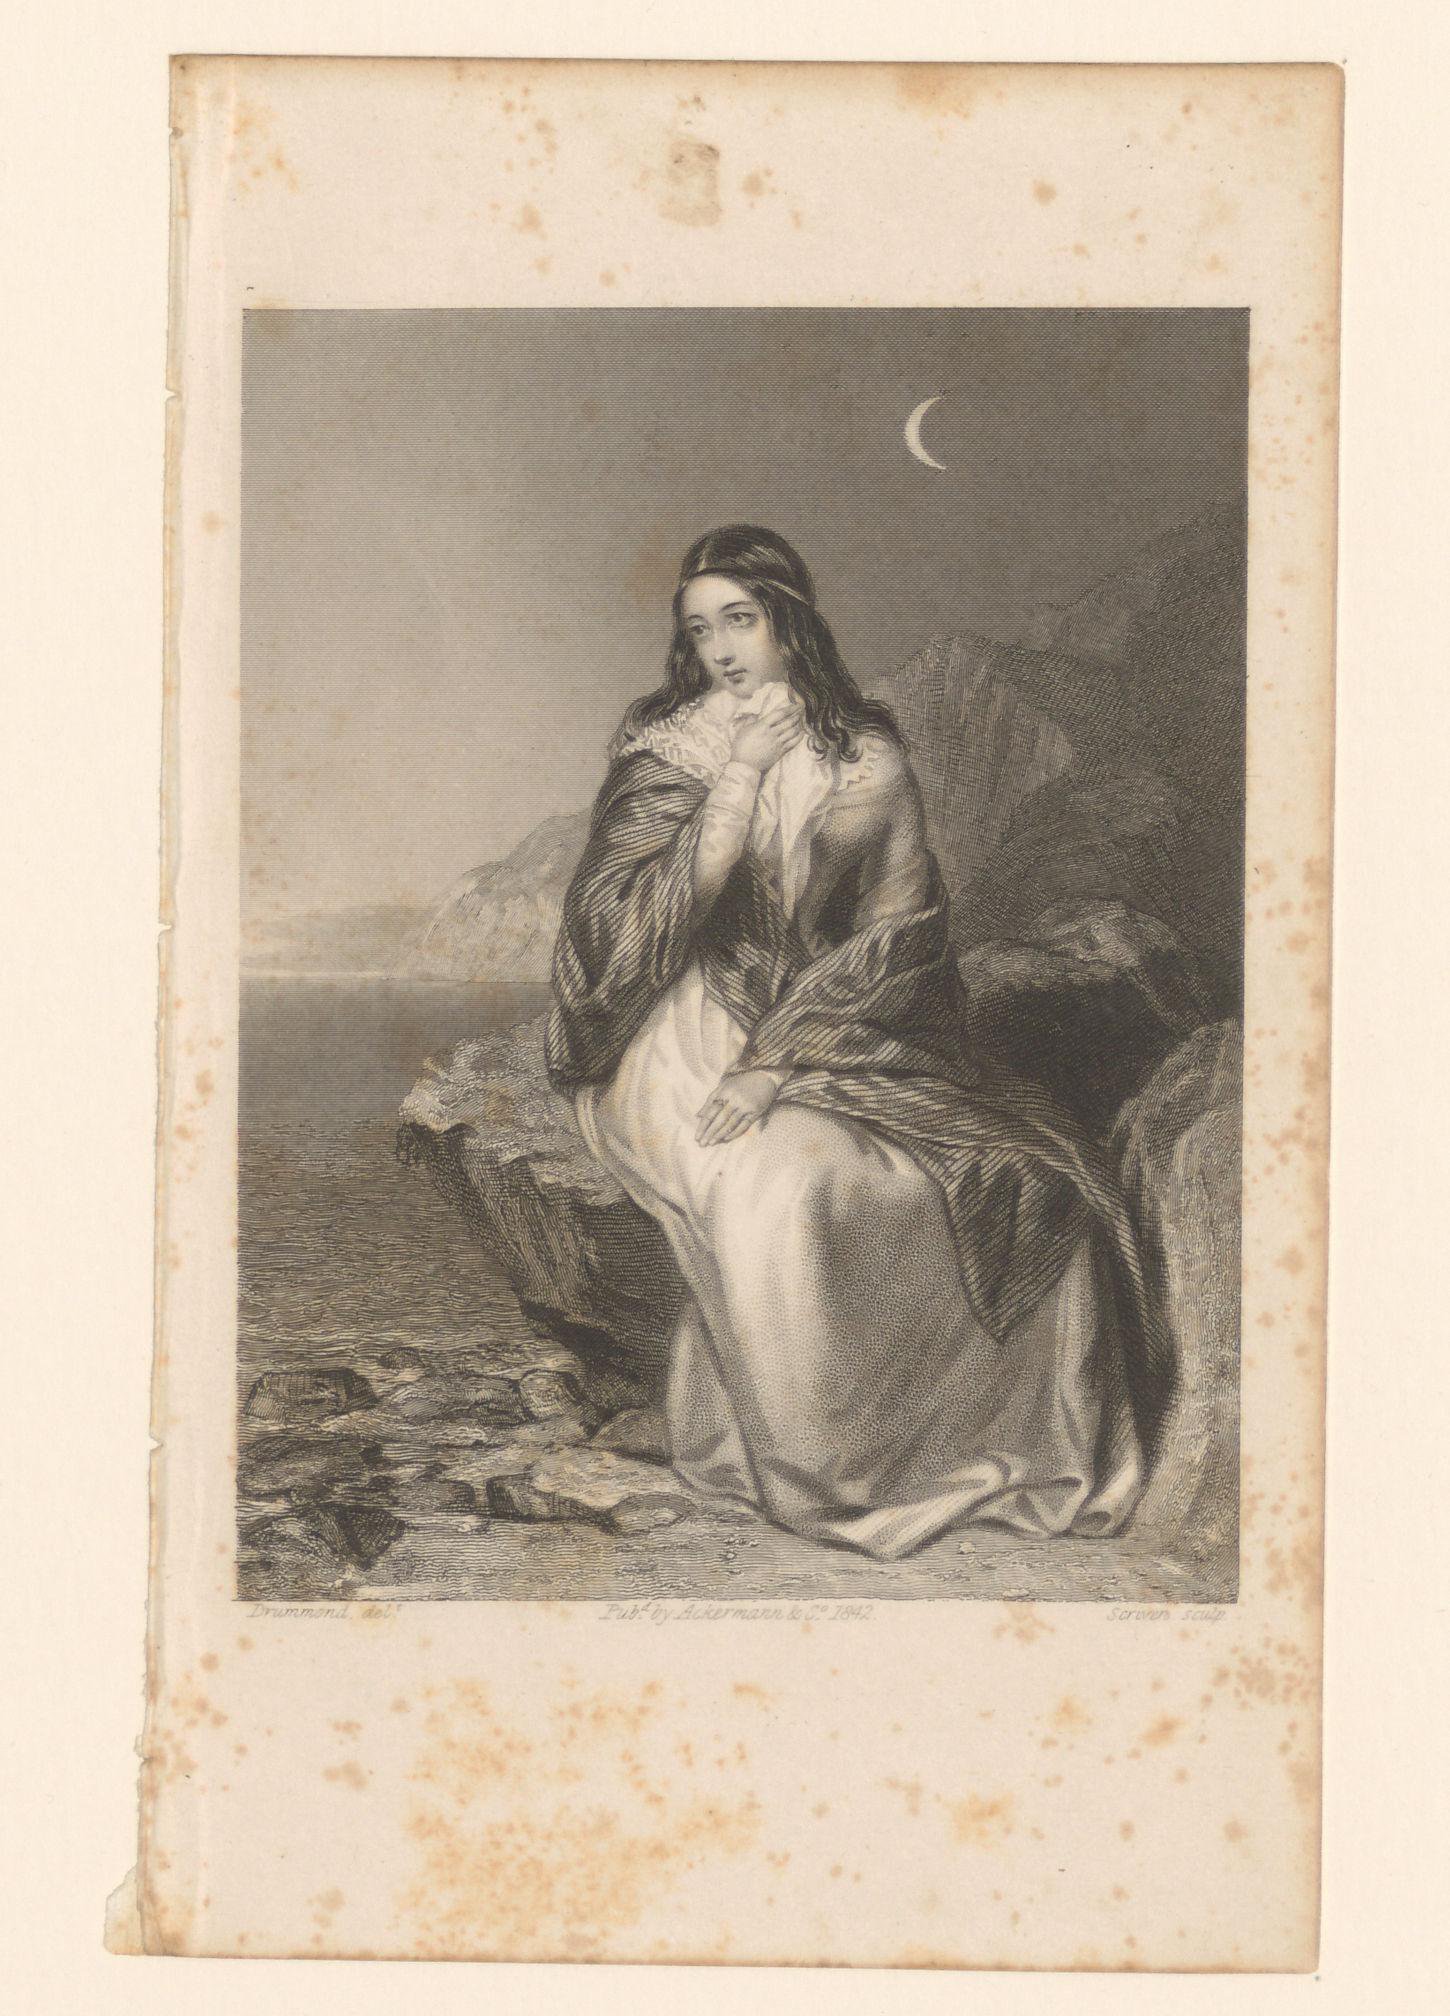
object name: print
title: Jonge vrouw op rotsachtige kust in het maanlicht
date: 1842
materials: paper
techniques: engraving, etching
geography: london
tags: adolescent, young woman, maiden, night ~ landscape (sometimes titled 'nox')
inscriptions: collector's mark: Lugt 2228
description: Prent is gebruikt in: Aurora. Jaarboekje voor 1842. Den Haag: J.I.D. Nepveu, 1842.